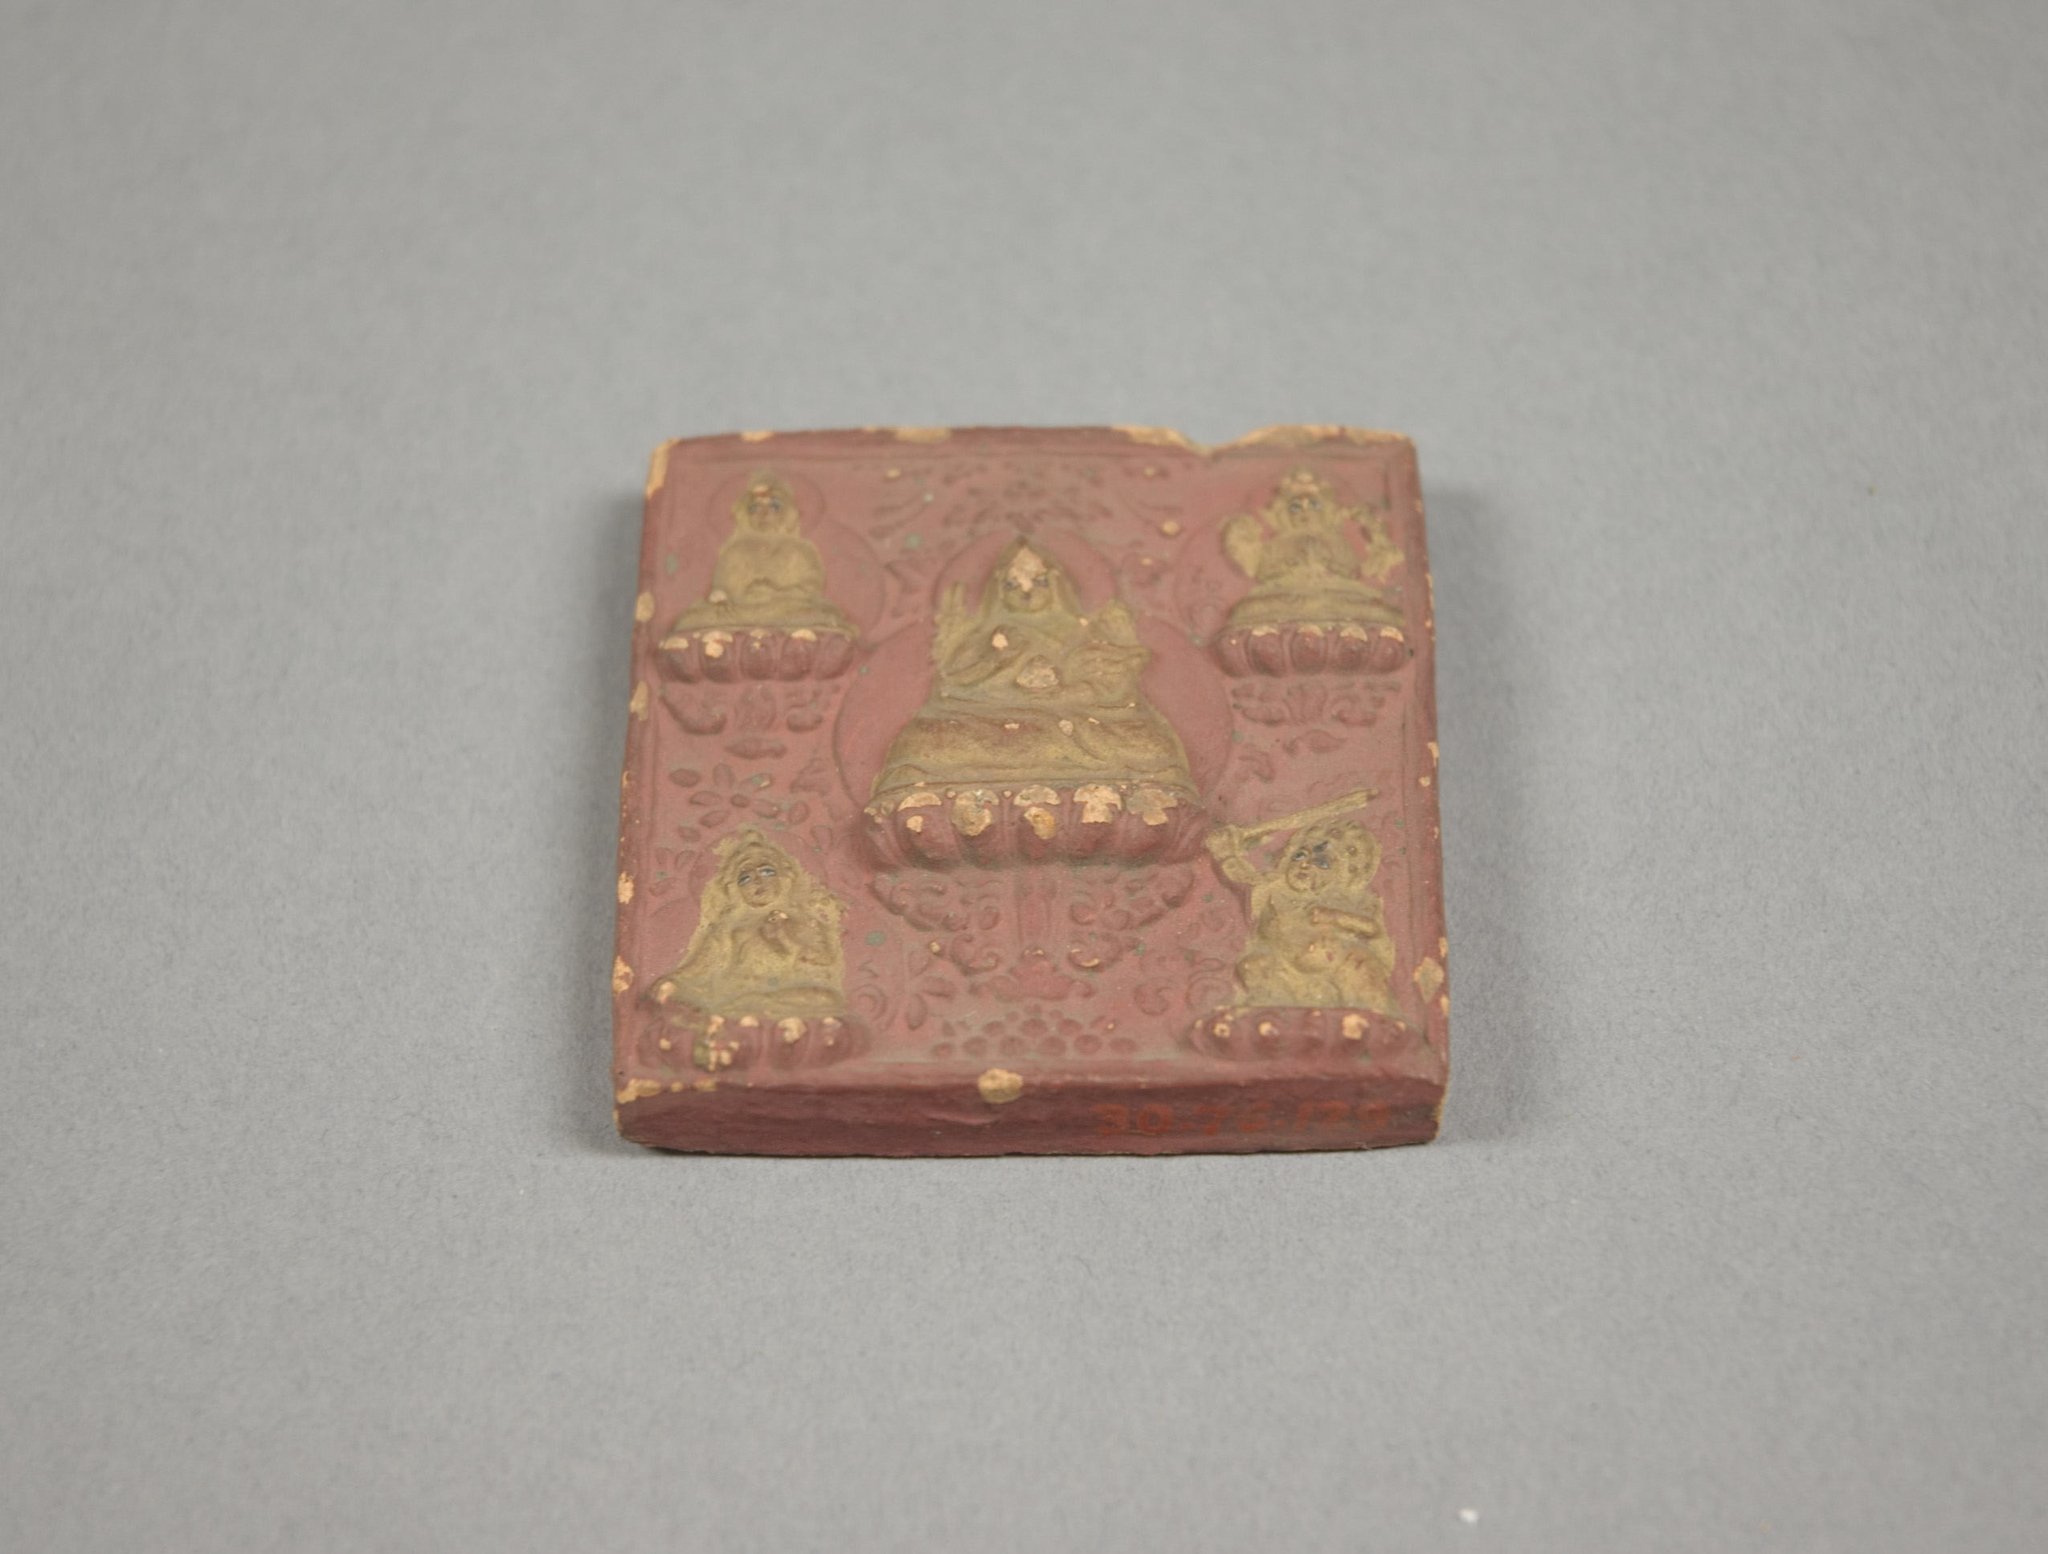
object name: votive tablet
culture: chinese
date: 1368-1644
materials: pottery